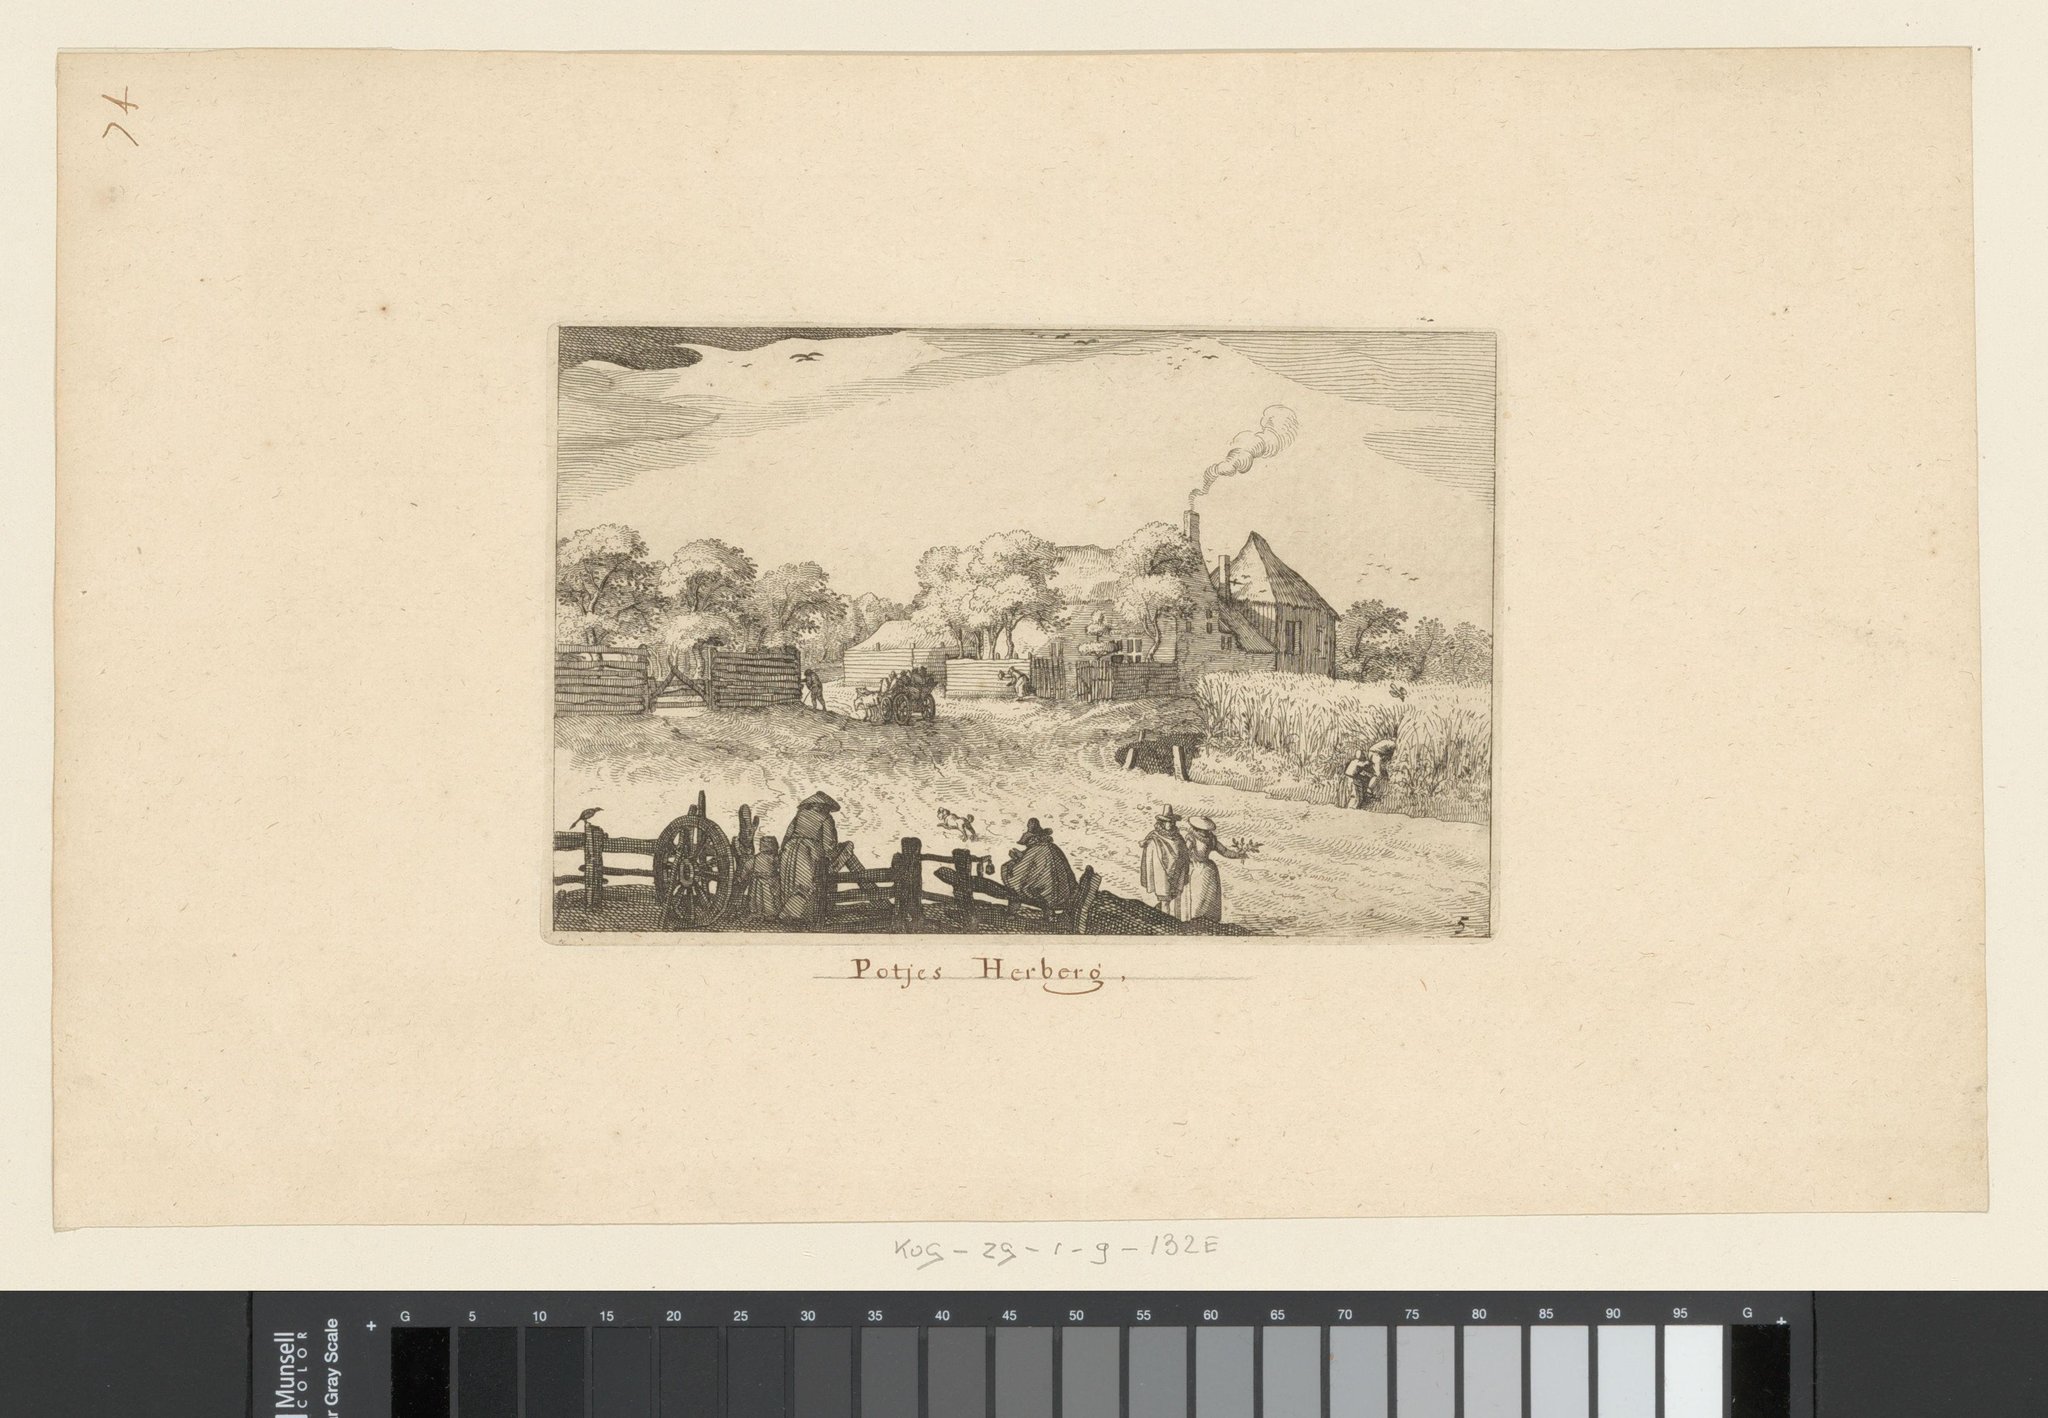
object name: print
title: Potjes herberg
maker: claes jansz. visscher (ii)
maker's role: draughtsman, print maker, publisher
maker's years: 1586-1652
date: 1611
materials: paper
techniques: etching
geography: amsterdam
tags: field filled with a crop, inn, coffee-house, public house, etc., dog, haarlem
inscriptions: stamp, collector's mark: Lugt 1641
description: Gezicht op een landweg waar een herberg met een rokende schoorsteen aan ligt. Op de voorgrond drie figuren en een wandelend paar bij een laag houten hek. Op de achtergrond verdwijnen twee figuren in een korenveld. Rechtsonder genummerd: 5. Onderwerpsrubrieken binnen de Atlas Zeden en Gewoonten: Handel, nijverheid en verkeer, Buitenleven.